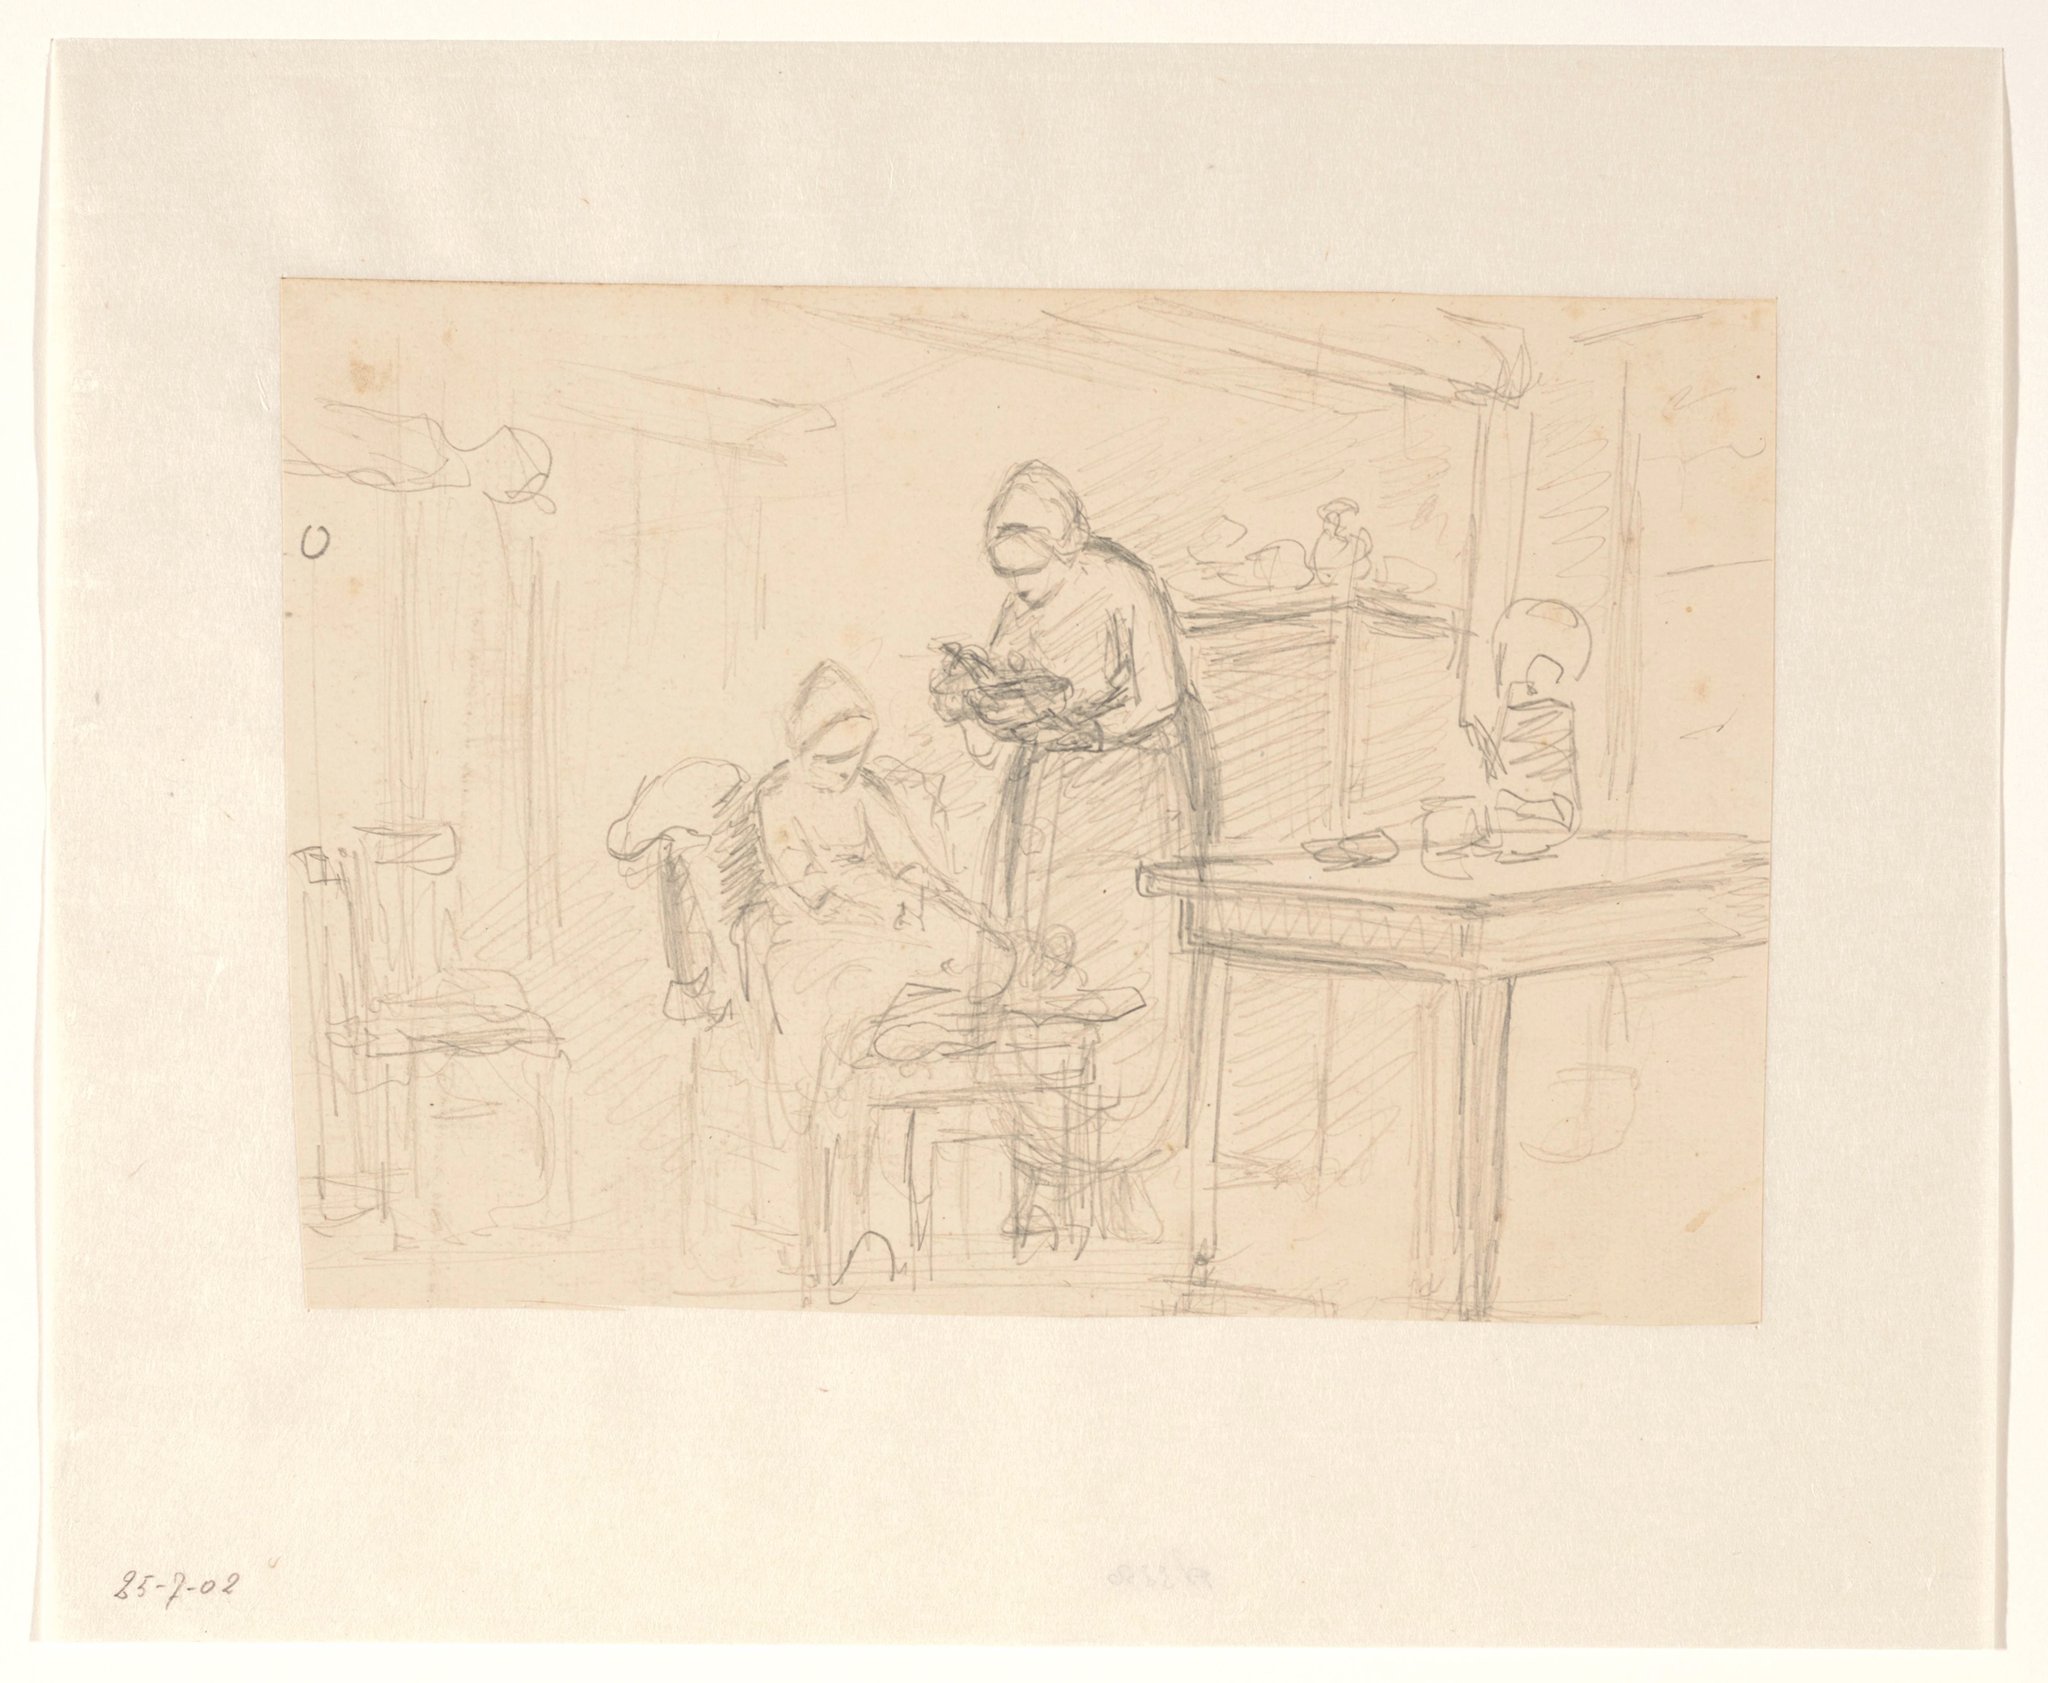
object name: drawing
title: Interieur met ziek meisje en moeder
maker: hendrik valkenburg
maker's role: draughtsman, painter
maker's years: 1826-1896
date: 1836-1896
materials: paper, pencil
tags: interior of the house, mother and child(ren), woman and child(ren) (family group)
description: Interieur met ziek meisje en moeder. Verso: Deel van een schouw met vrouw en kind.